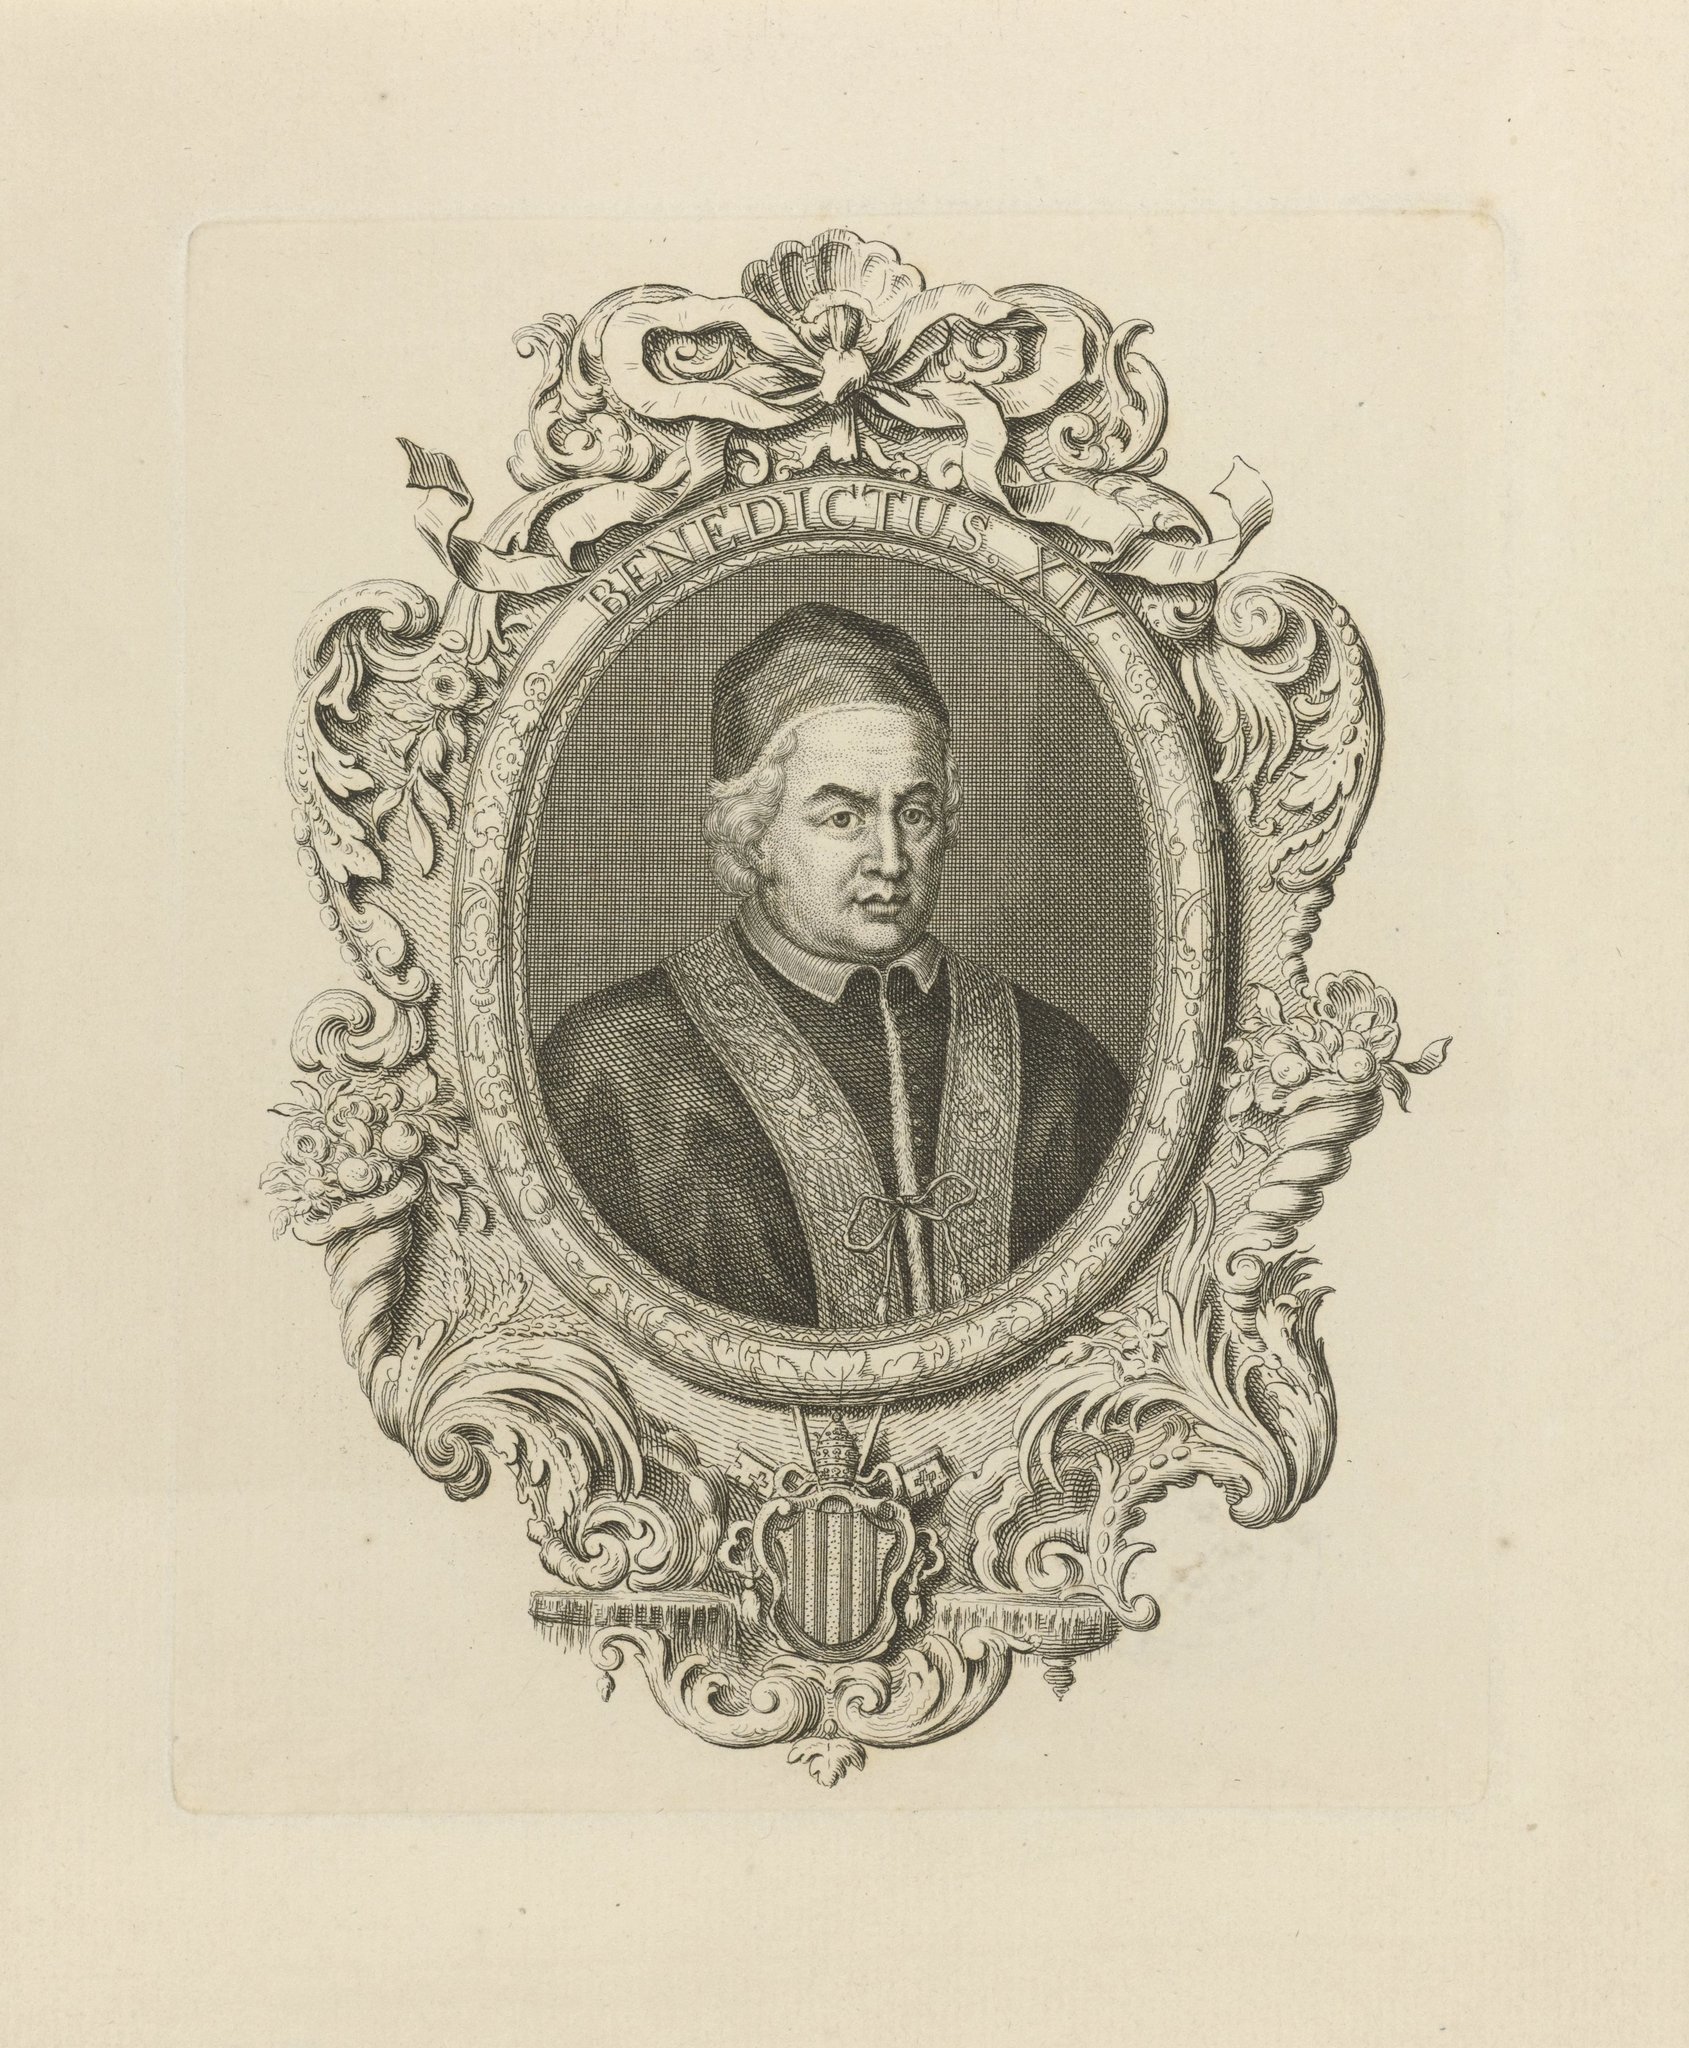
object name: print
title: Portret van paus Benedictus XIV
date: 1683-1733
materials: paper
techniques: engraving, etching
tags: benedictus xiv, pope, armorial bearing, heraldry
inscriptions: collector's mark: Lugt 240